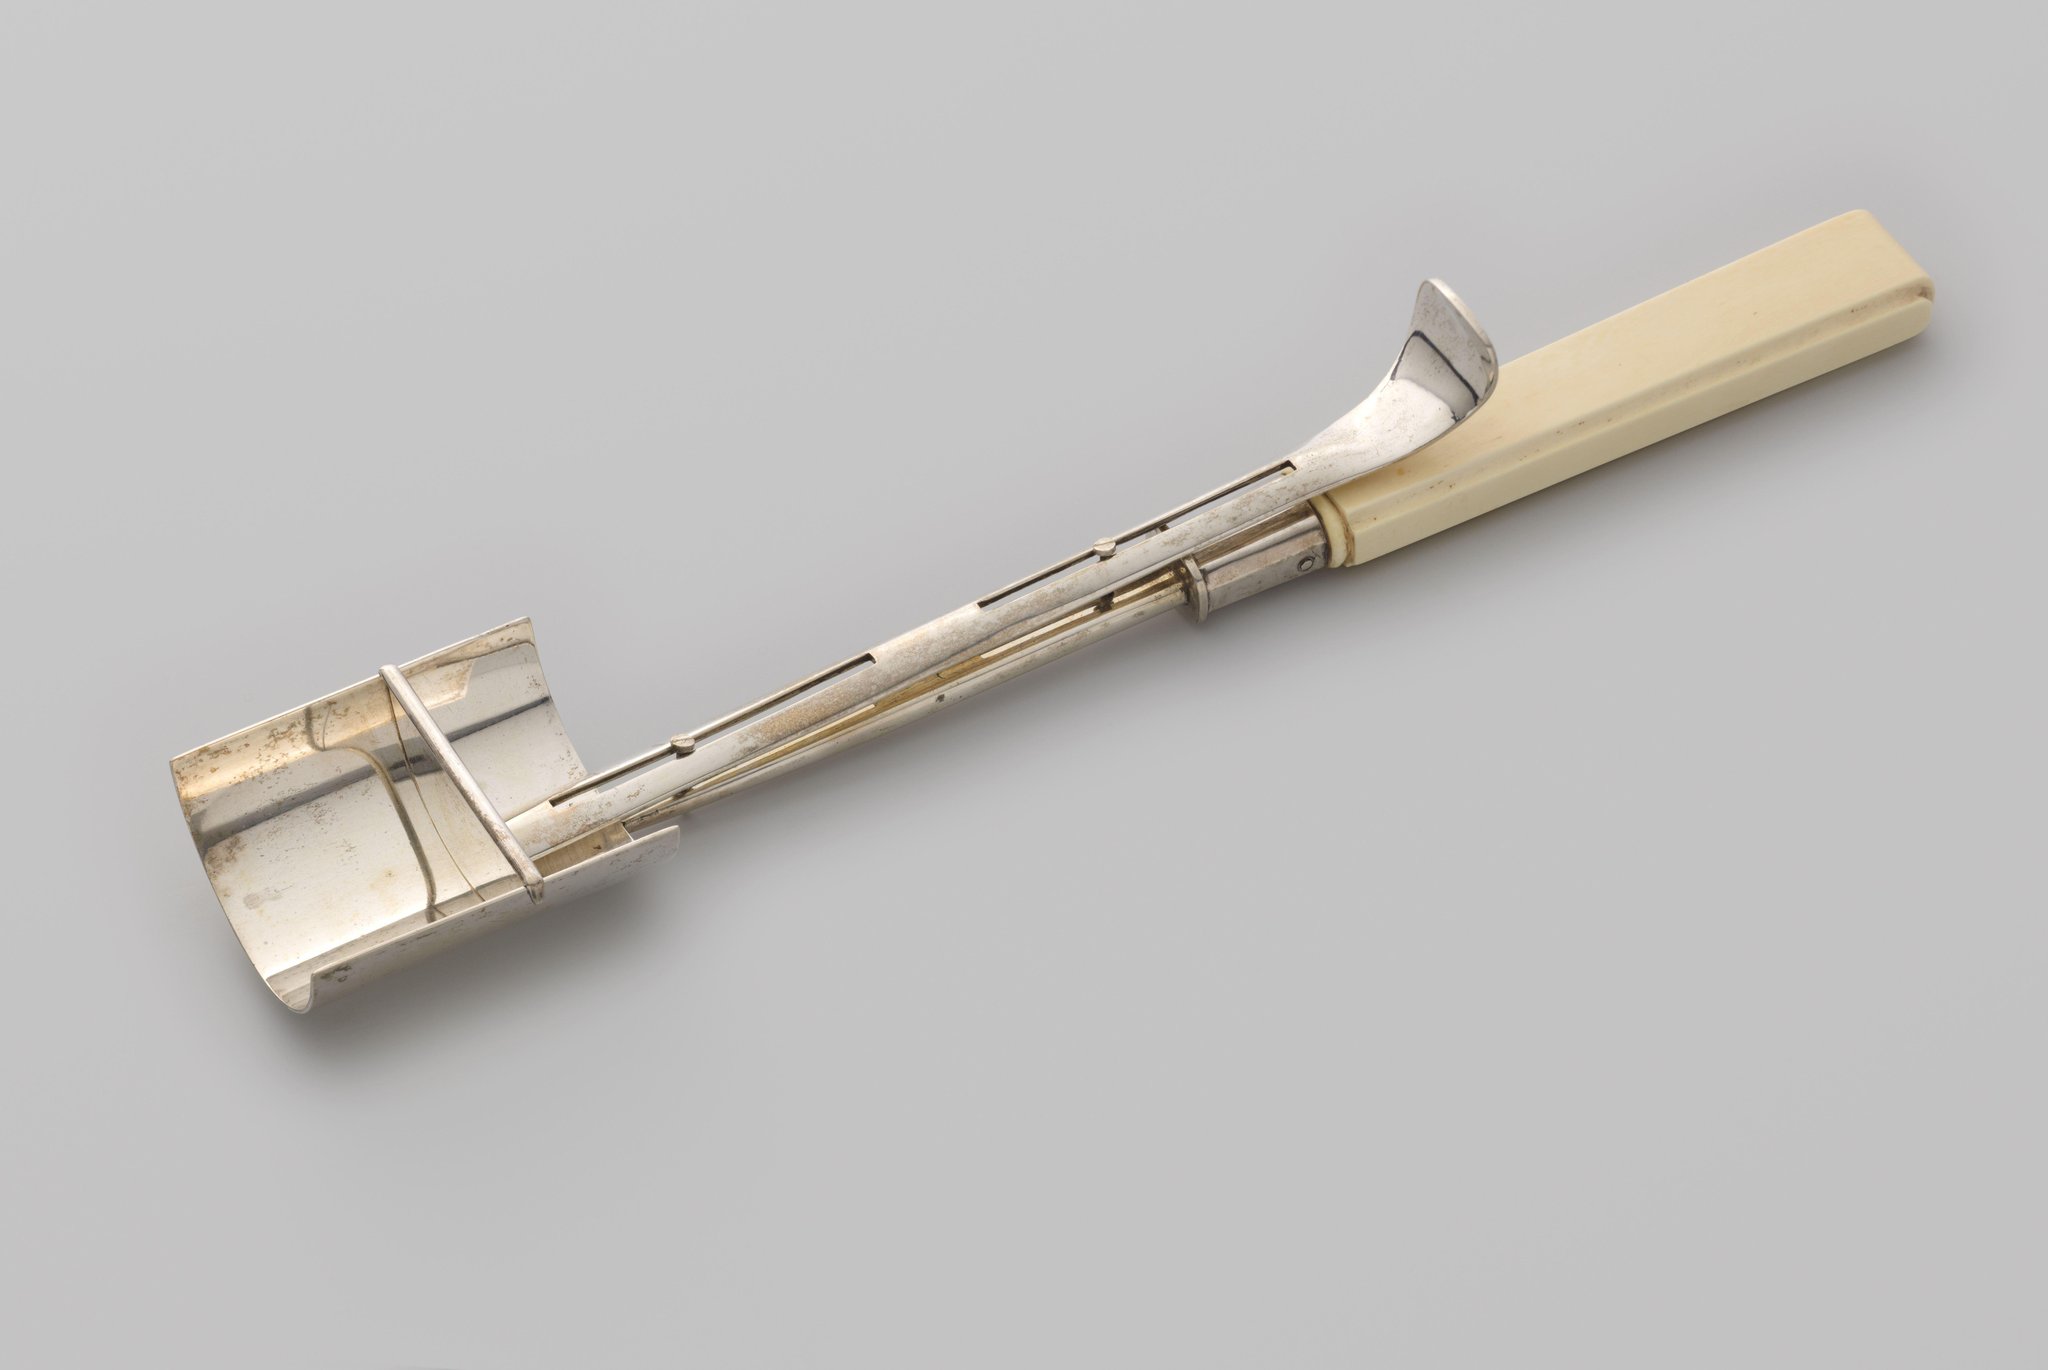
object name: ijssteker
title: IJssteker met ivoren handgreep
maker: pierre louis uriot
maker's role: silversmith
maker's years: 1785-1864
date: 1850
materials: ivory, silver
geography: amsterdam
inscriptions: assay office mark, date letter: ‘Q’, maker's mark, hallmark, alloy mark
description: De half-cilindervormige boor is door middel van een naald, die zich geleidelijk verbreedt tot een steel van ovale doorsnede, verbonden met een zich eveneens verbredend, rechthoekig aanzetstuk met afgeschuinde hoeken. In de boor past een door een rond profiel afgesloten schuif met een holle steel die eindigt in een platte, omhoog gekrulde, zich verbredende duimgreep. In deze steel bevinden zich twee langwerpige openingen, die passen rond in de steel van de boor bevestigde schroeven. Met de duimgreep kan de schuif in de boor worden bewogen, totdat de schroeven de steel afremmen. Aan de steel van de boor is een ivoren, zich verbredend handvat bevestigd, dat rechthoekig van doorsnede is met afgeschuinde, ingezwenkte hoeken, die aan het rechte uiteinde omlopen.